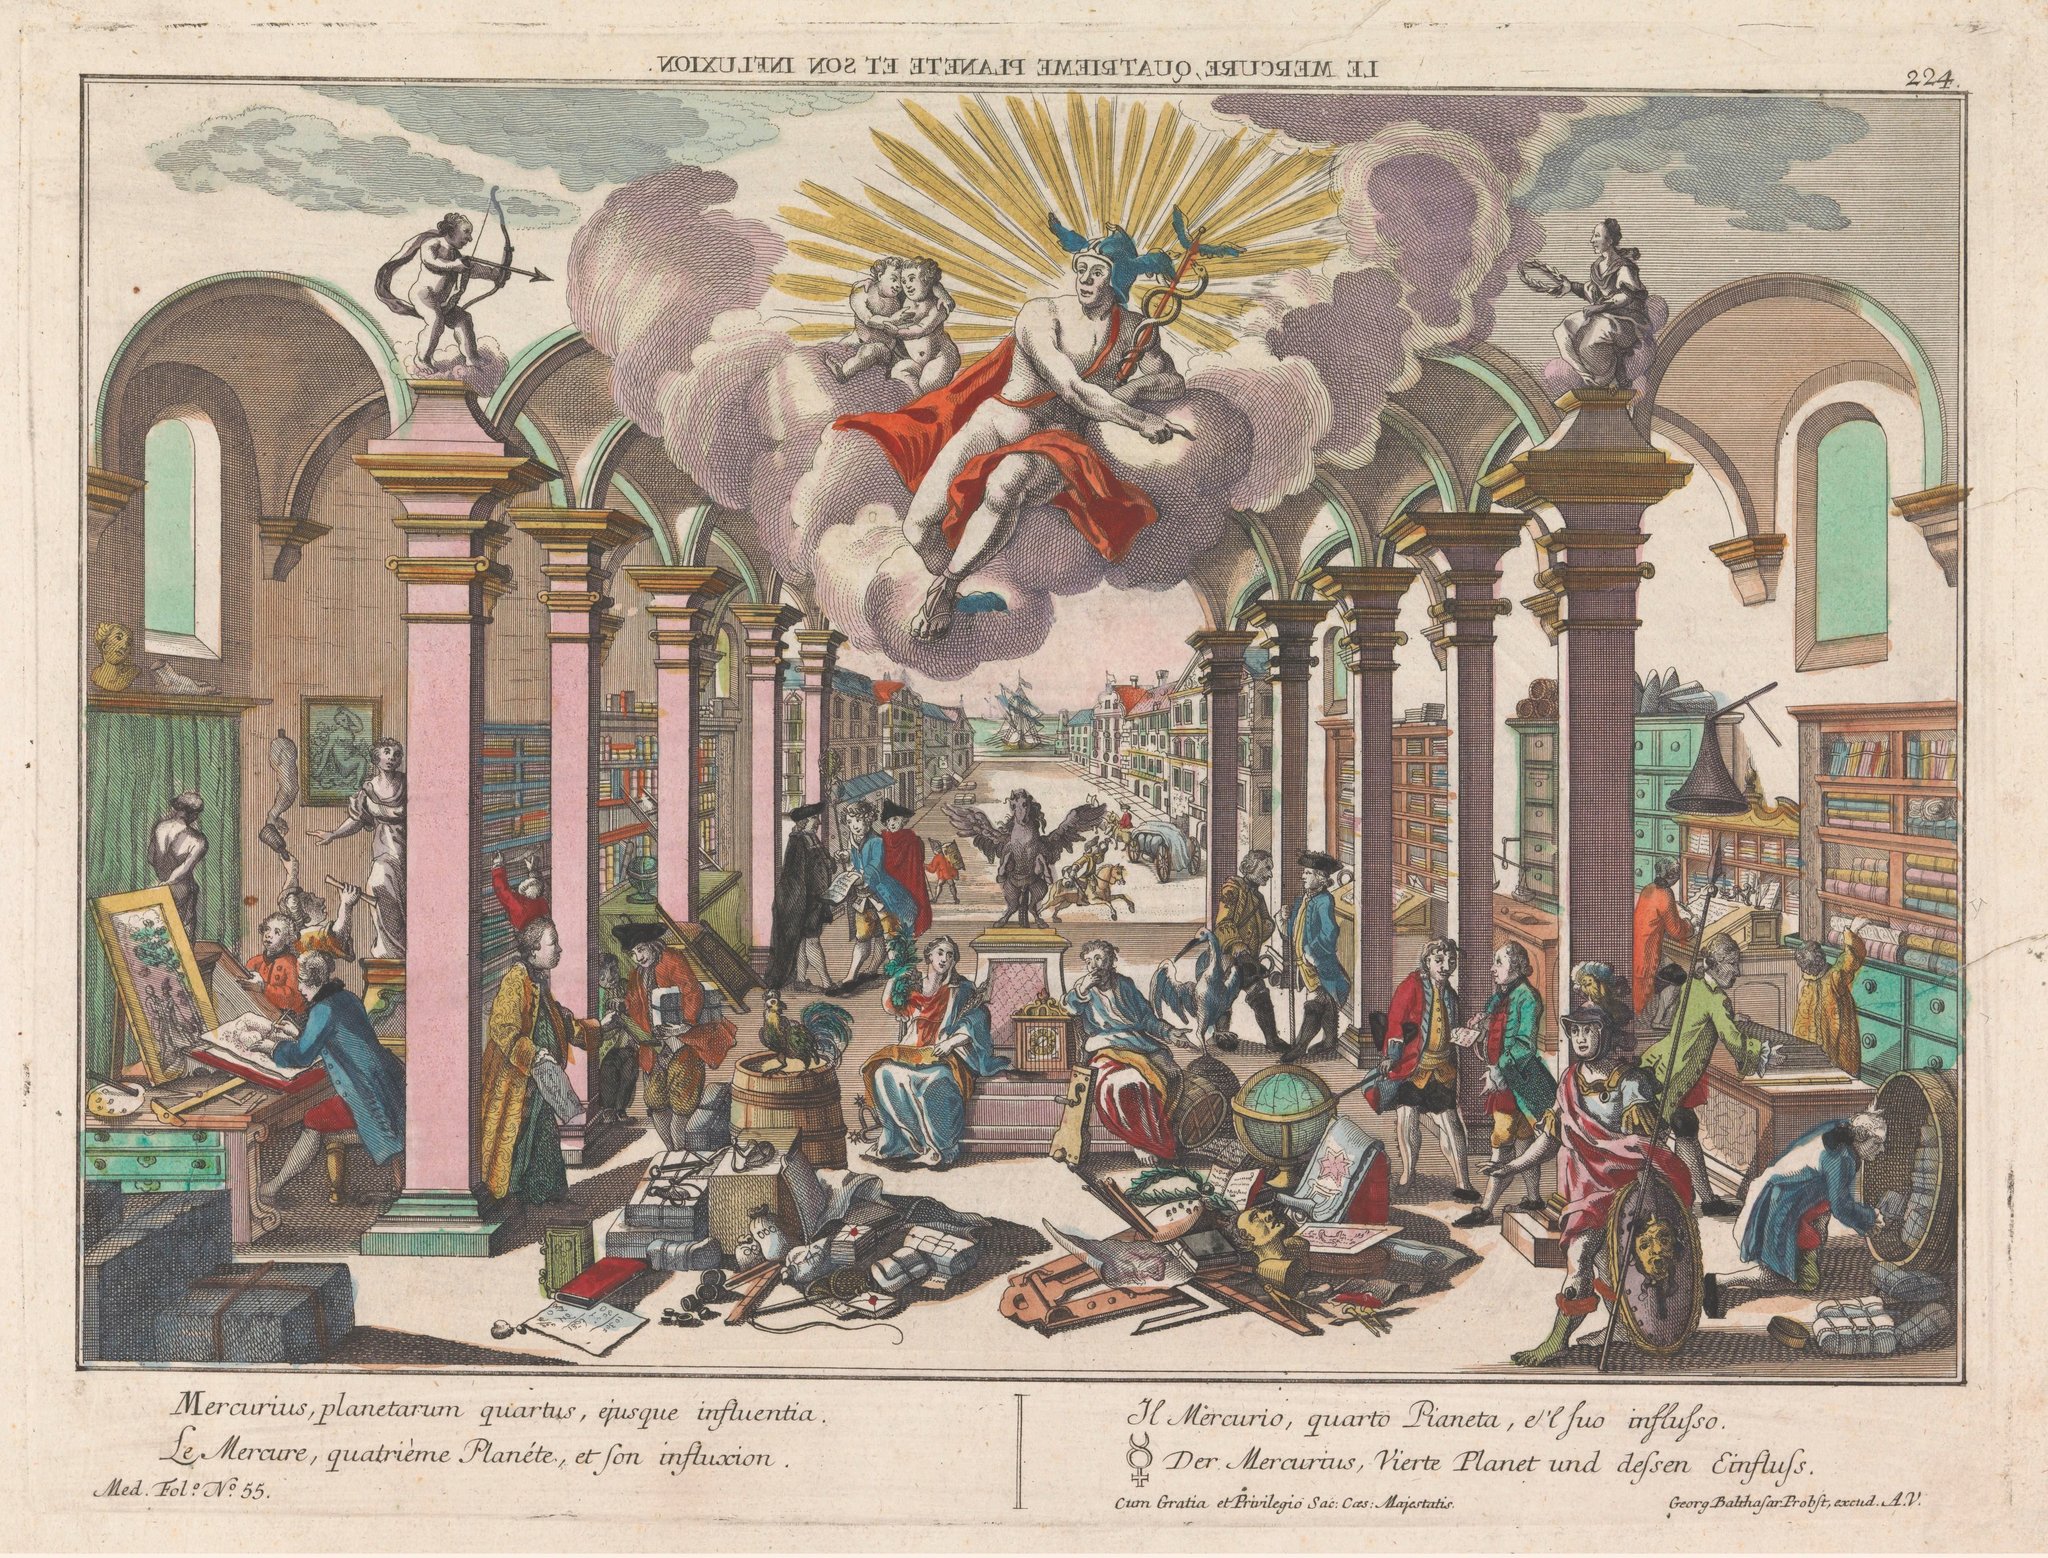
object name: opticaprent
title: Allegorie op de planeet Mercurius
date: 1742-1801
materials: paper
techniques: etching, hand coloring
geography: germany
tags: sculptor at work, draughtsman at work, book, symbolic representations, allegories and emblems ~ art; 'arte' (ripa), specific aspects, allegorical aspects of mercury; mercury as patron, book-shop, bookseller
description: In de lucht zit Mercurius met twee putti op een wolk. Op de grond links zijn een beeldhouwer en twee kunstenaars aan het werk. Daarnaast overhandigt een man een boek aan een rondreizende koopman. In het midden twee stapels met objecten, gerelateerd aan de handel en de kunsten. Rechts het interieur van een boekhandel met een man die een ton met boeken inpakt. Rechtsboven genummerd: 226. Linksonder genummerd: 55.